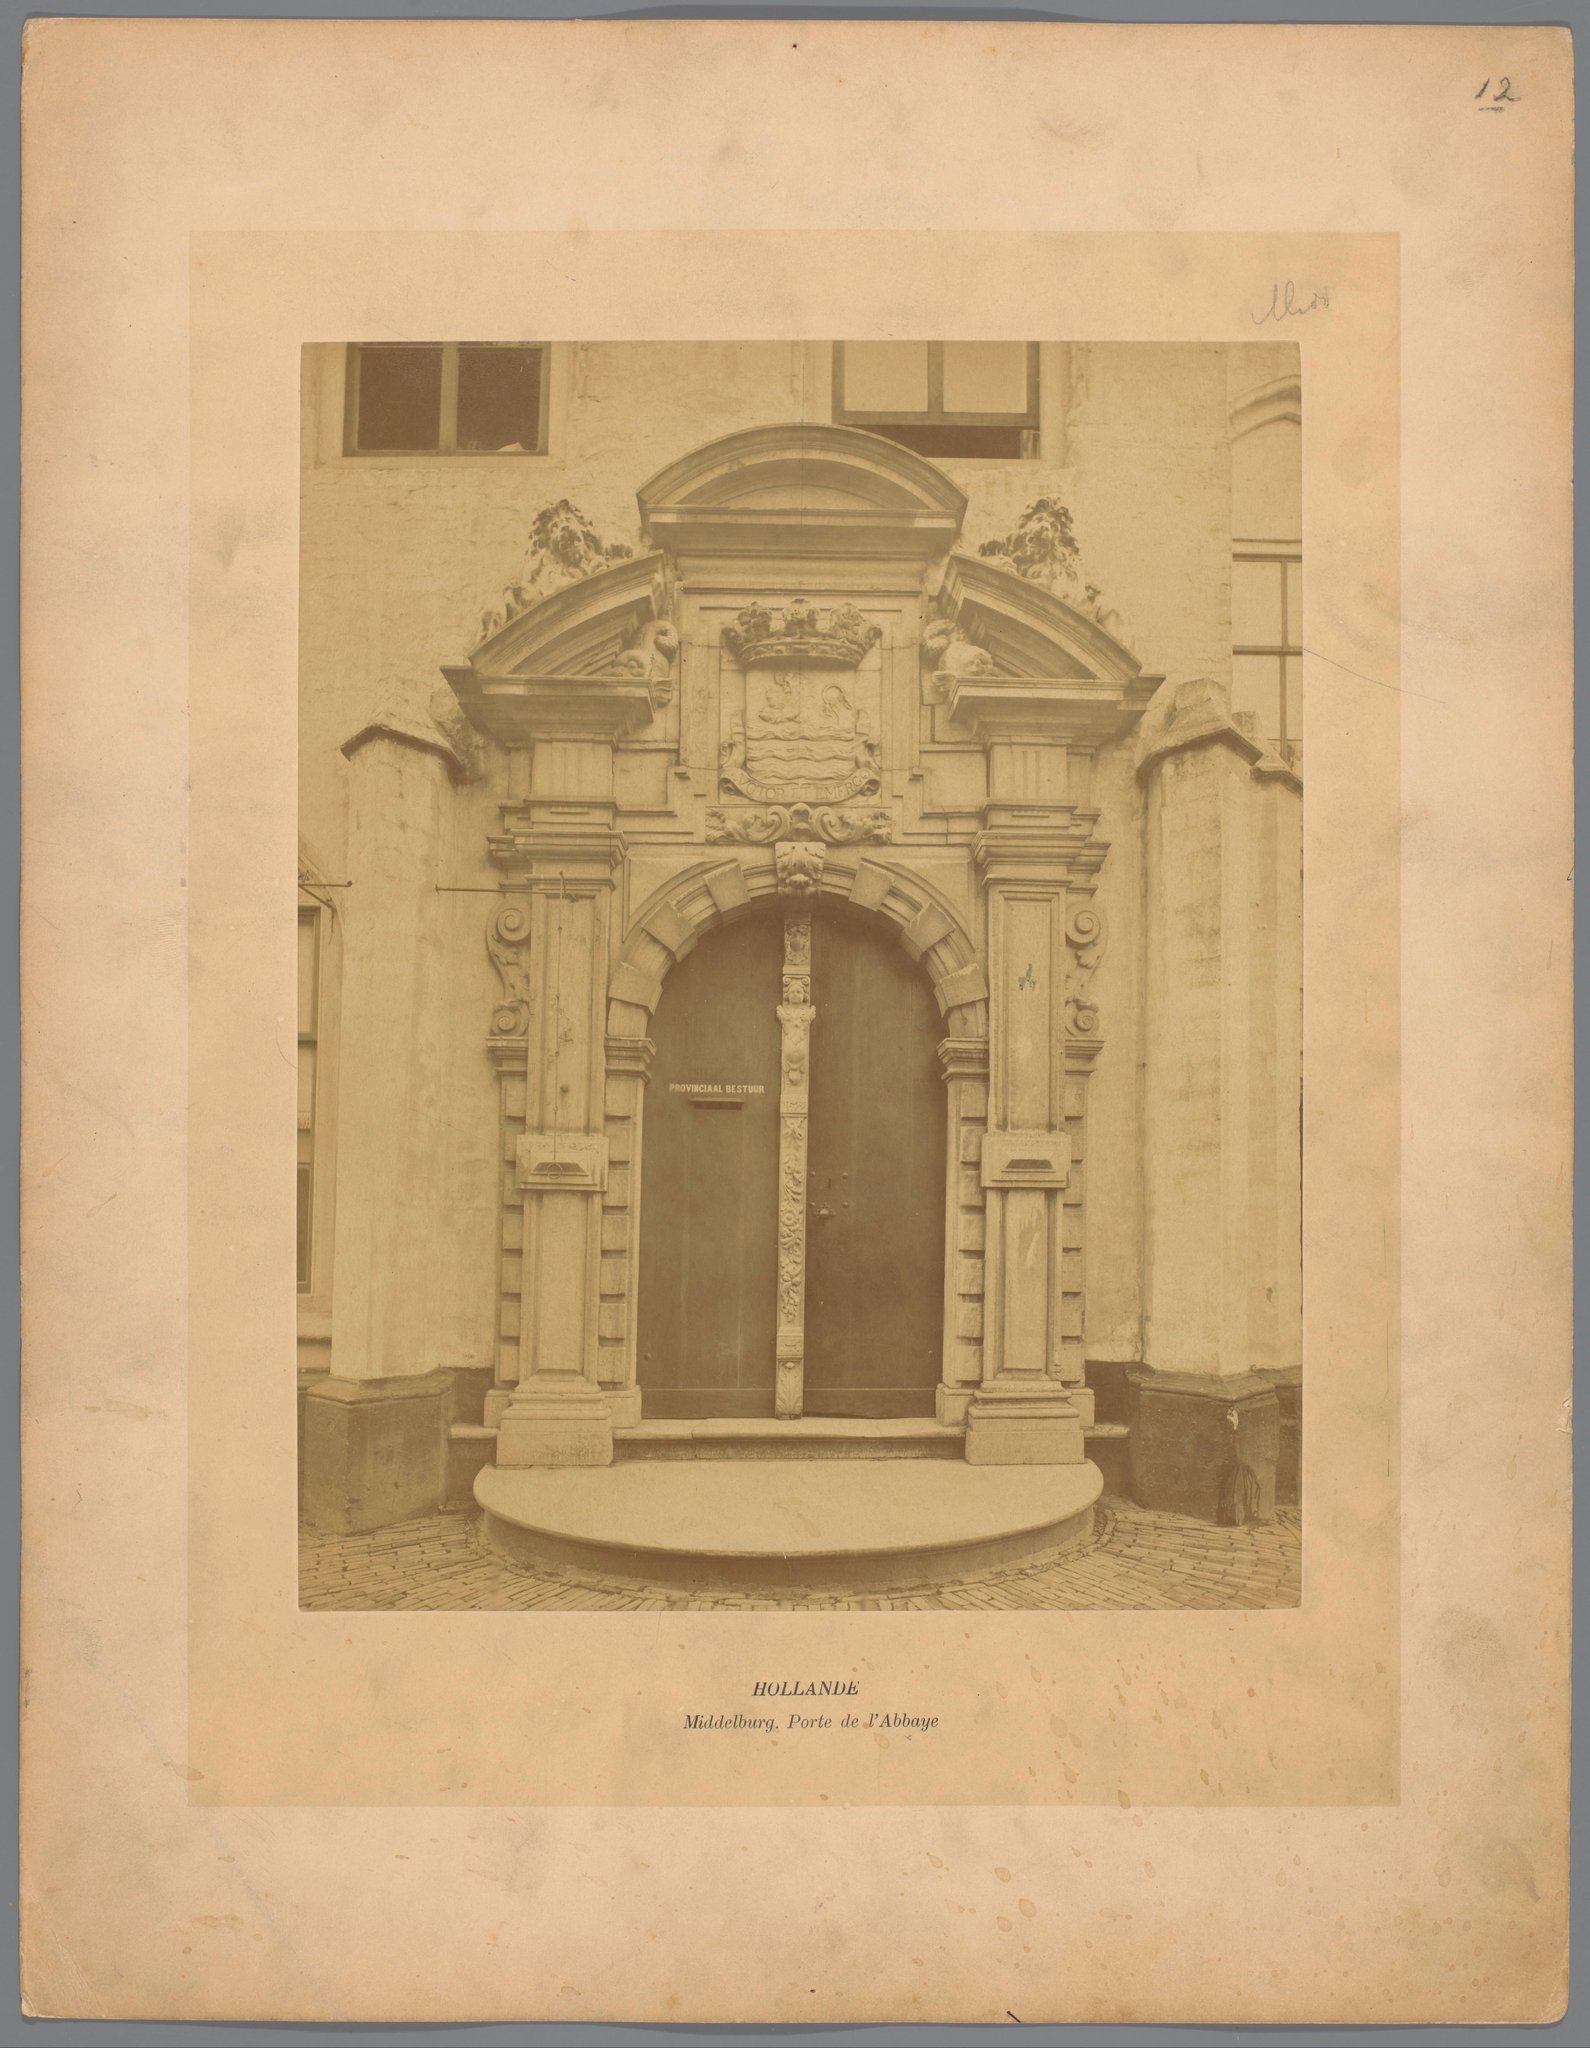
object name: photograph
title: Toegangspoort van de Onze-Lieve-Vrouwe abdij te Middelburg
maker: Anonymous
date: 1875-1900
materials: cardboard, photographic support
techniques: albumen print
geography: middelburg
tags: abbey, monastery, convent ~ roman catholic church, gate, entrance, armorial bearing, heraldry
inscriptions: collector's mark: Lugt 3937, inscription: ‘HOLLANDE Middelburg. Porte de l'Abbaye’